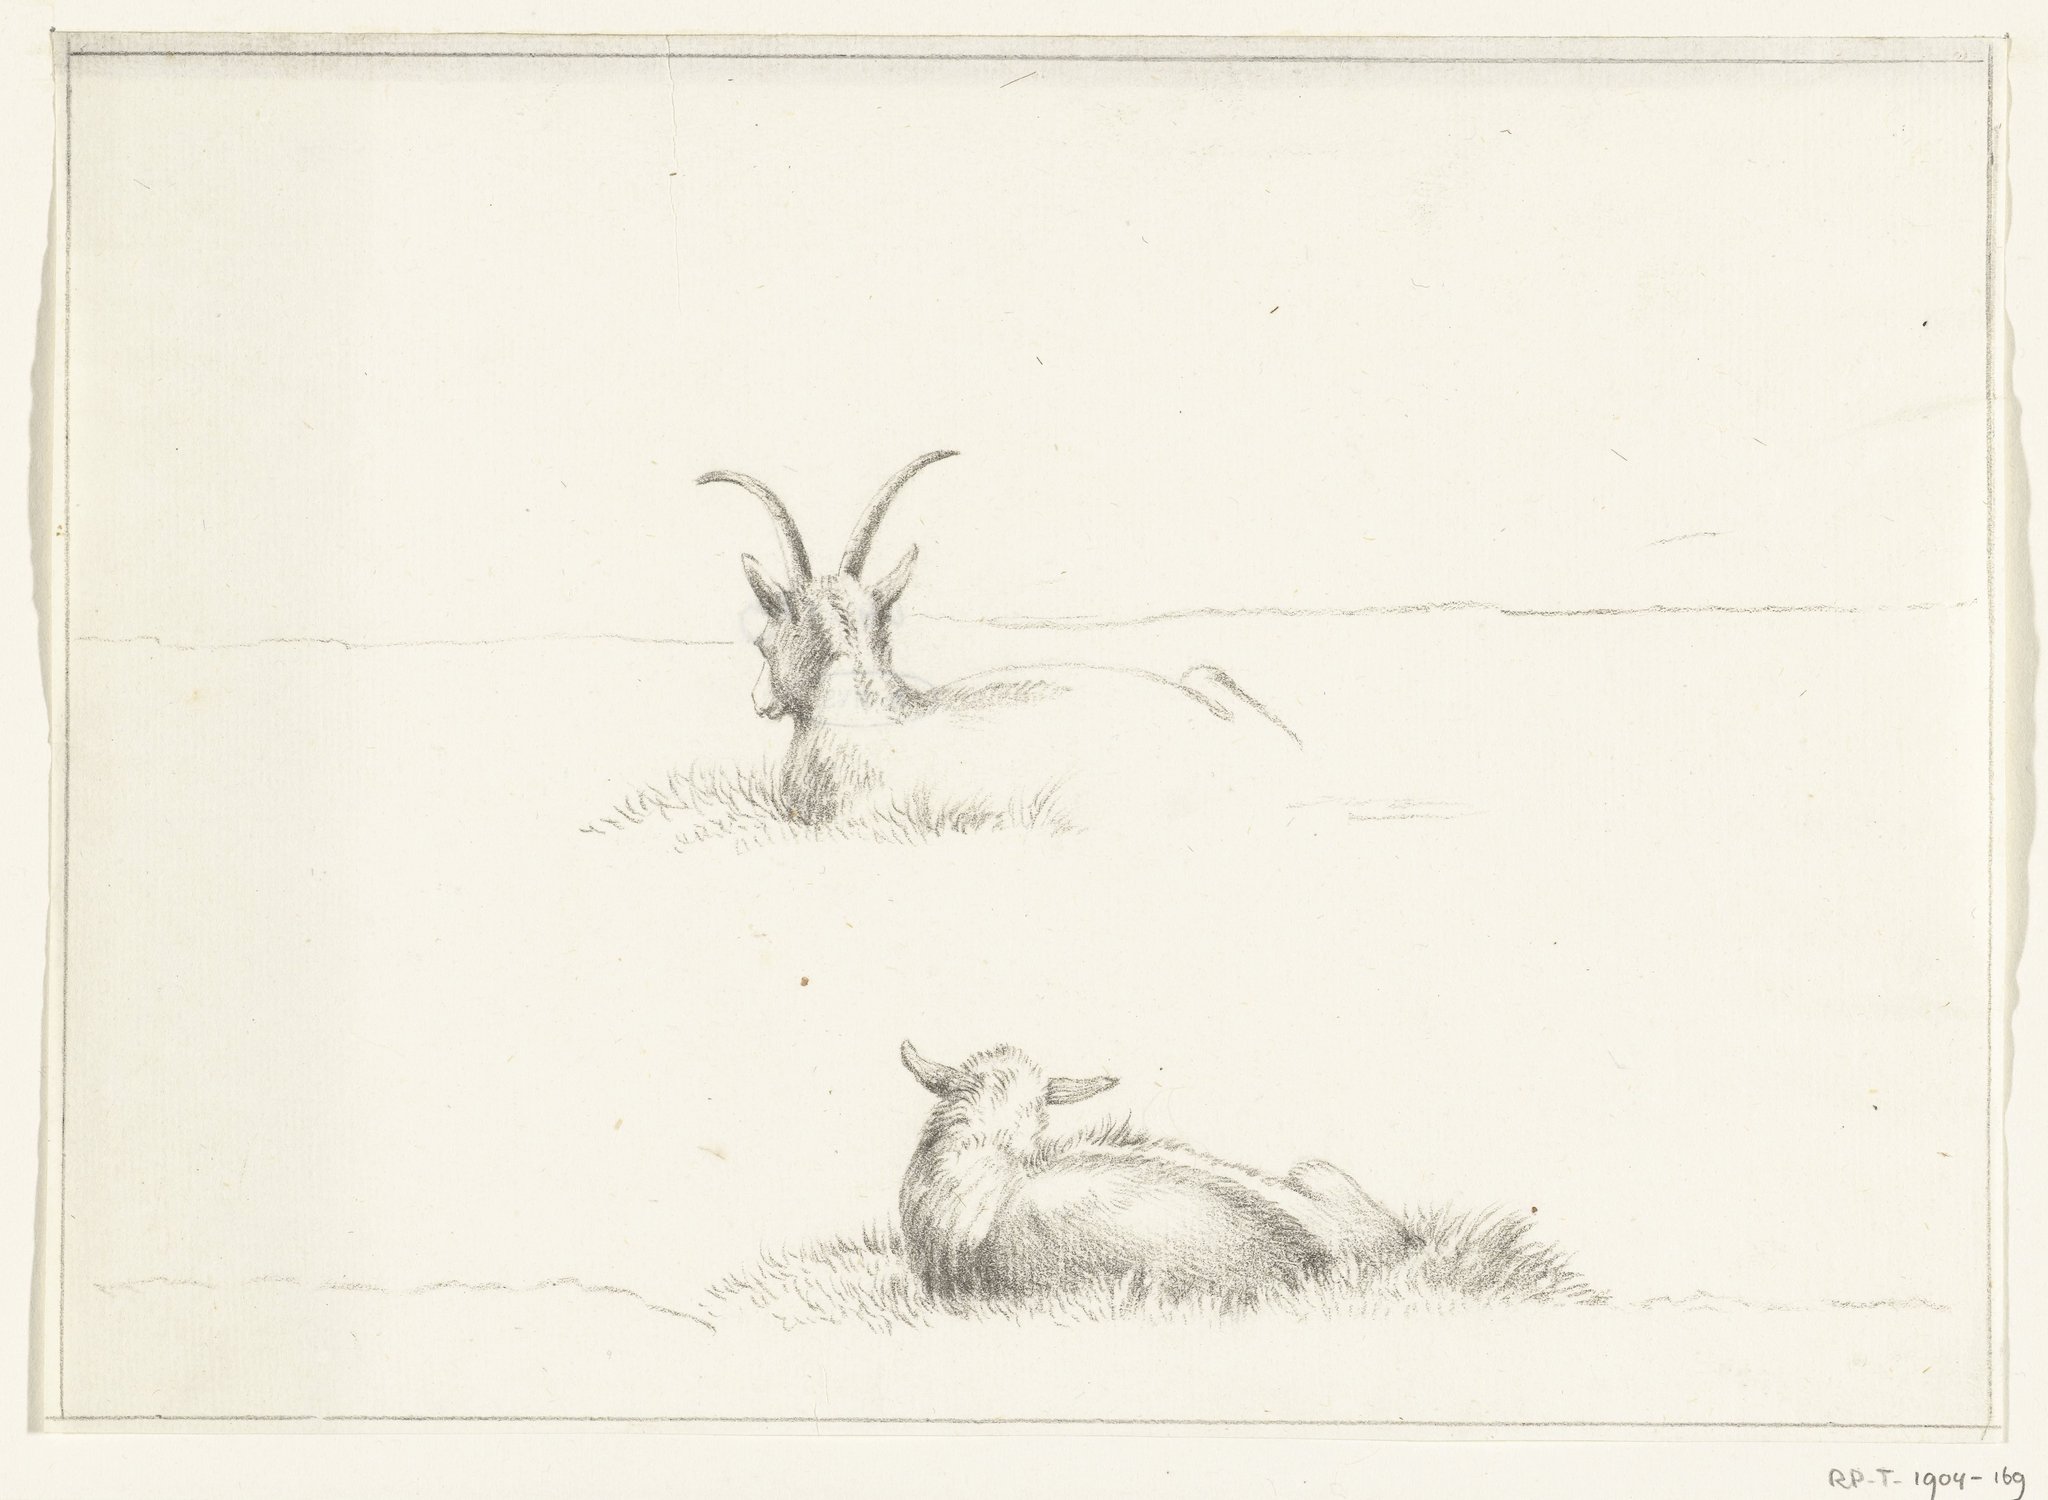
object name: drawing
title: Schetsen van een liggende geit en een schaap, van achteren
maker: jean bernard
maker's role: draughtsman, print maker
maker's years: 1765-1833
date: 1775-1833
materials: chalk, paper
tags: sheep, goat